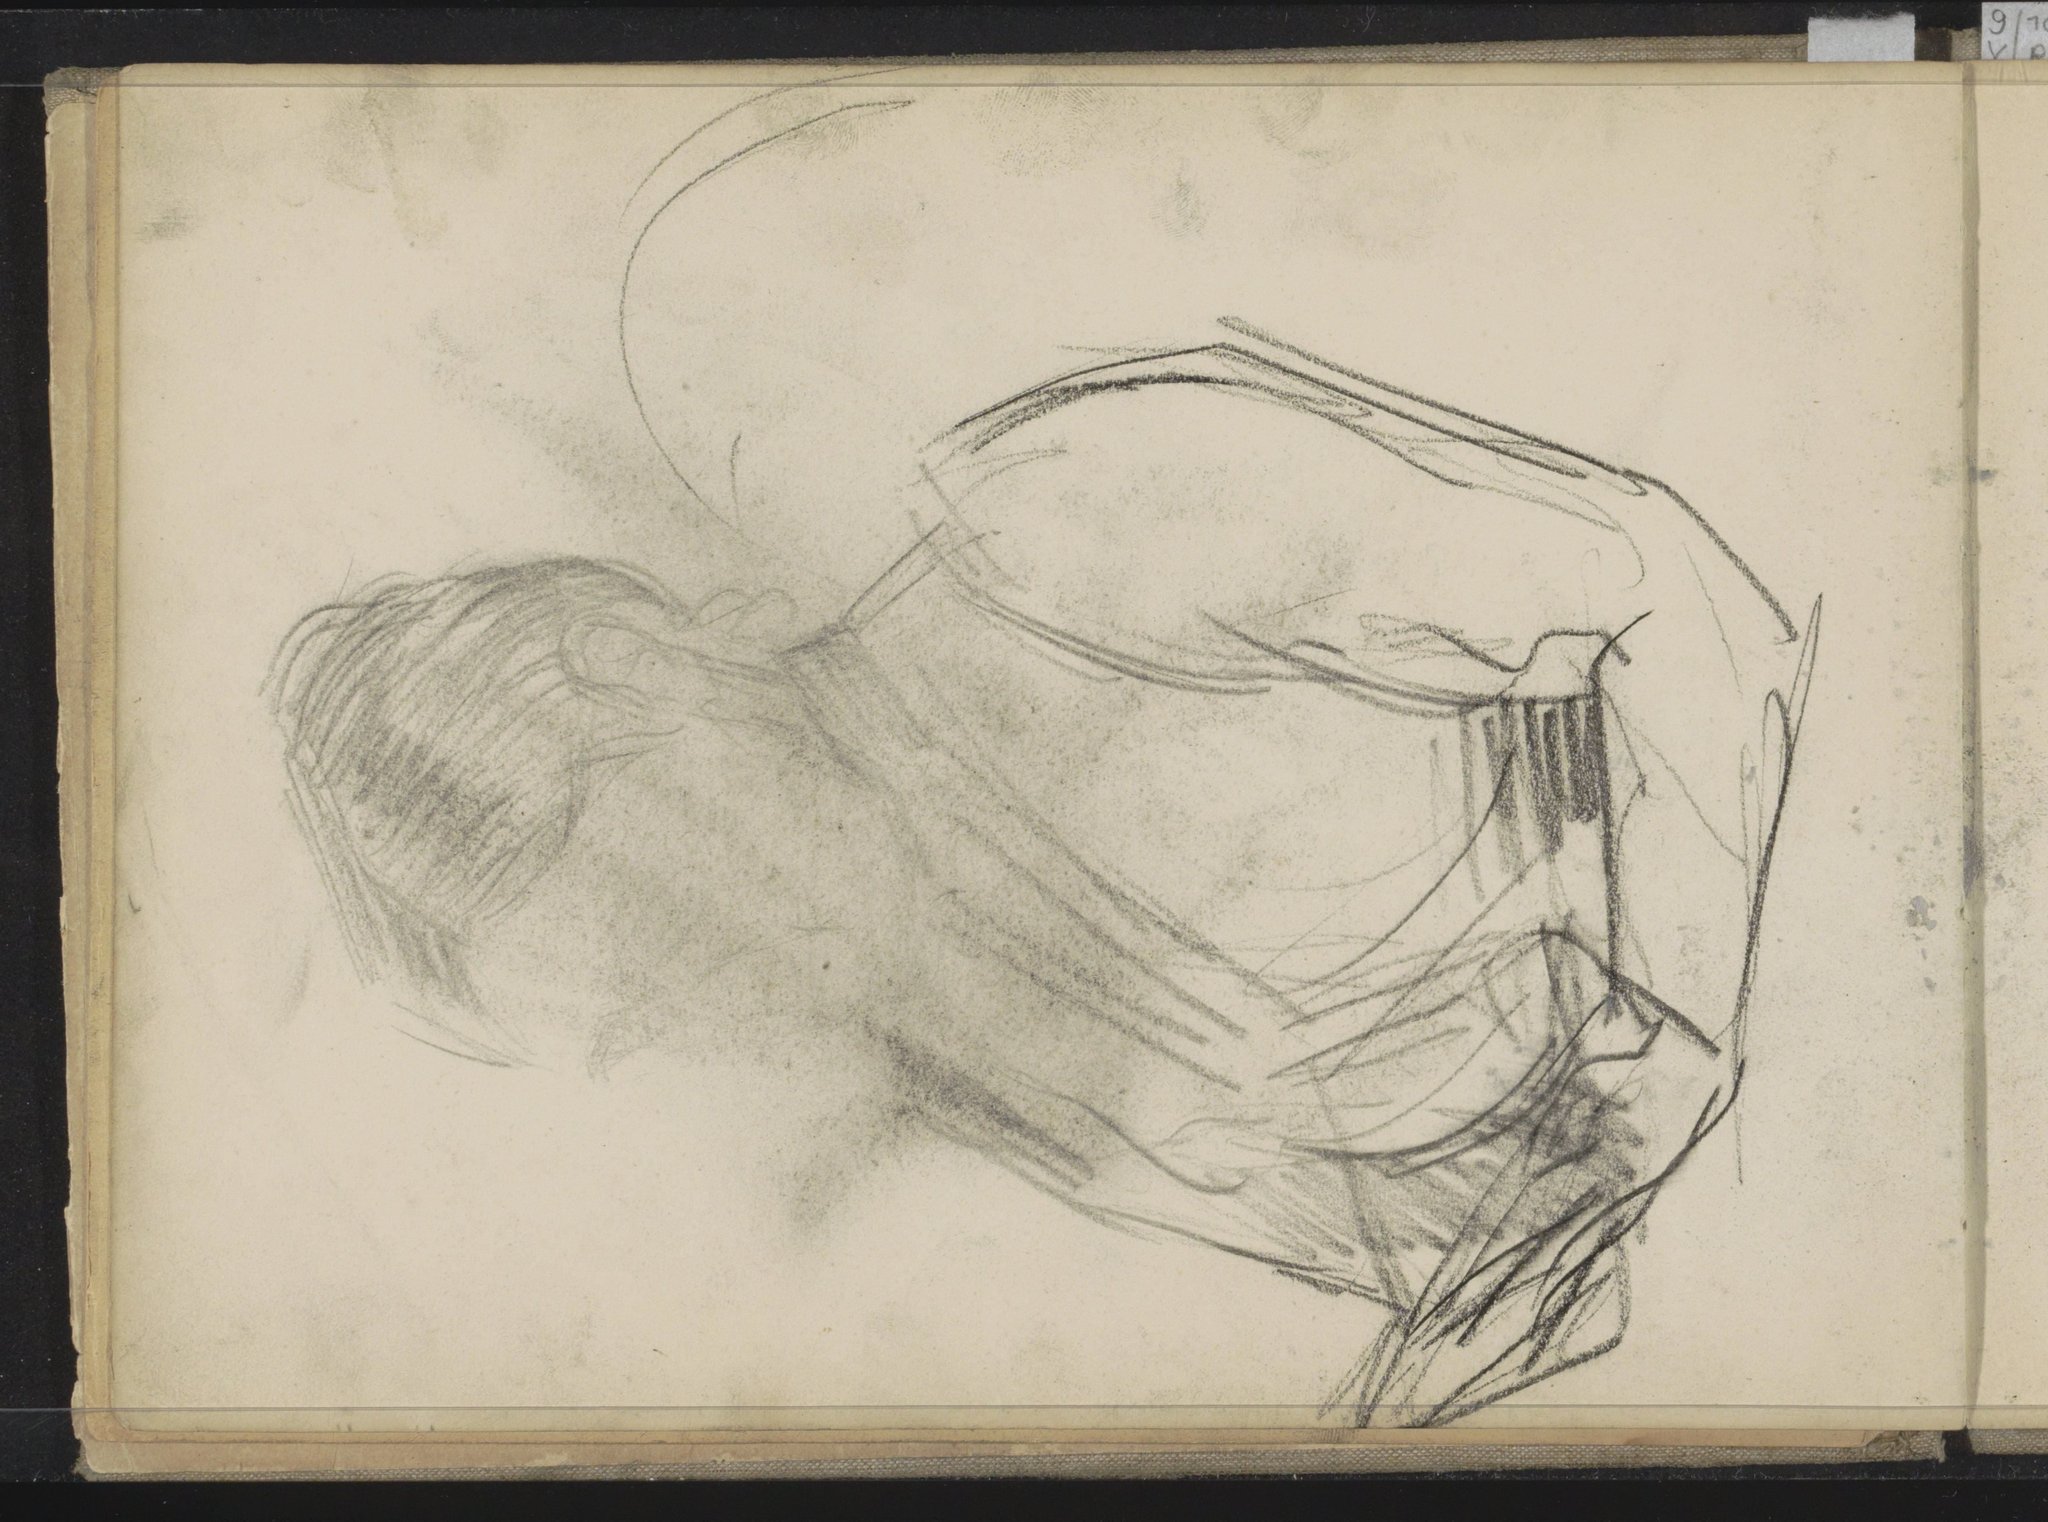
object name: sketchbook leaf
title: Lezende vrouw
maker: johanna van de kamer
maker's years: 1873-1922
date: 1890-1922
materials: chalk, paper, pencil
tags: adult woman, reading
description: Blad 5 verso uit een schetsboek met 11 bladen.